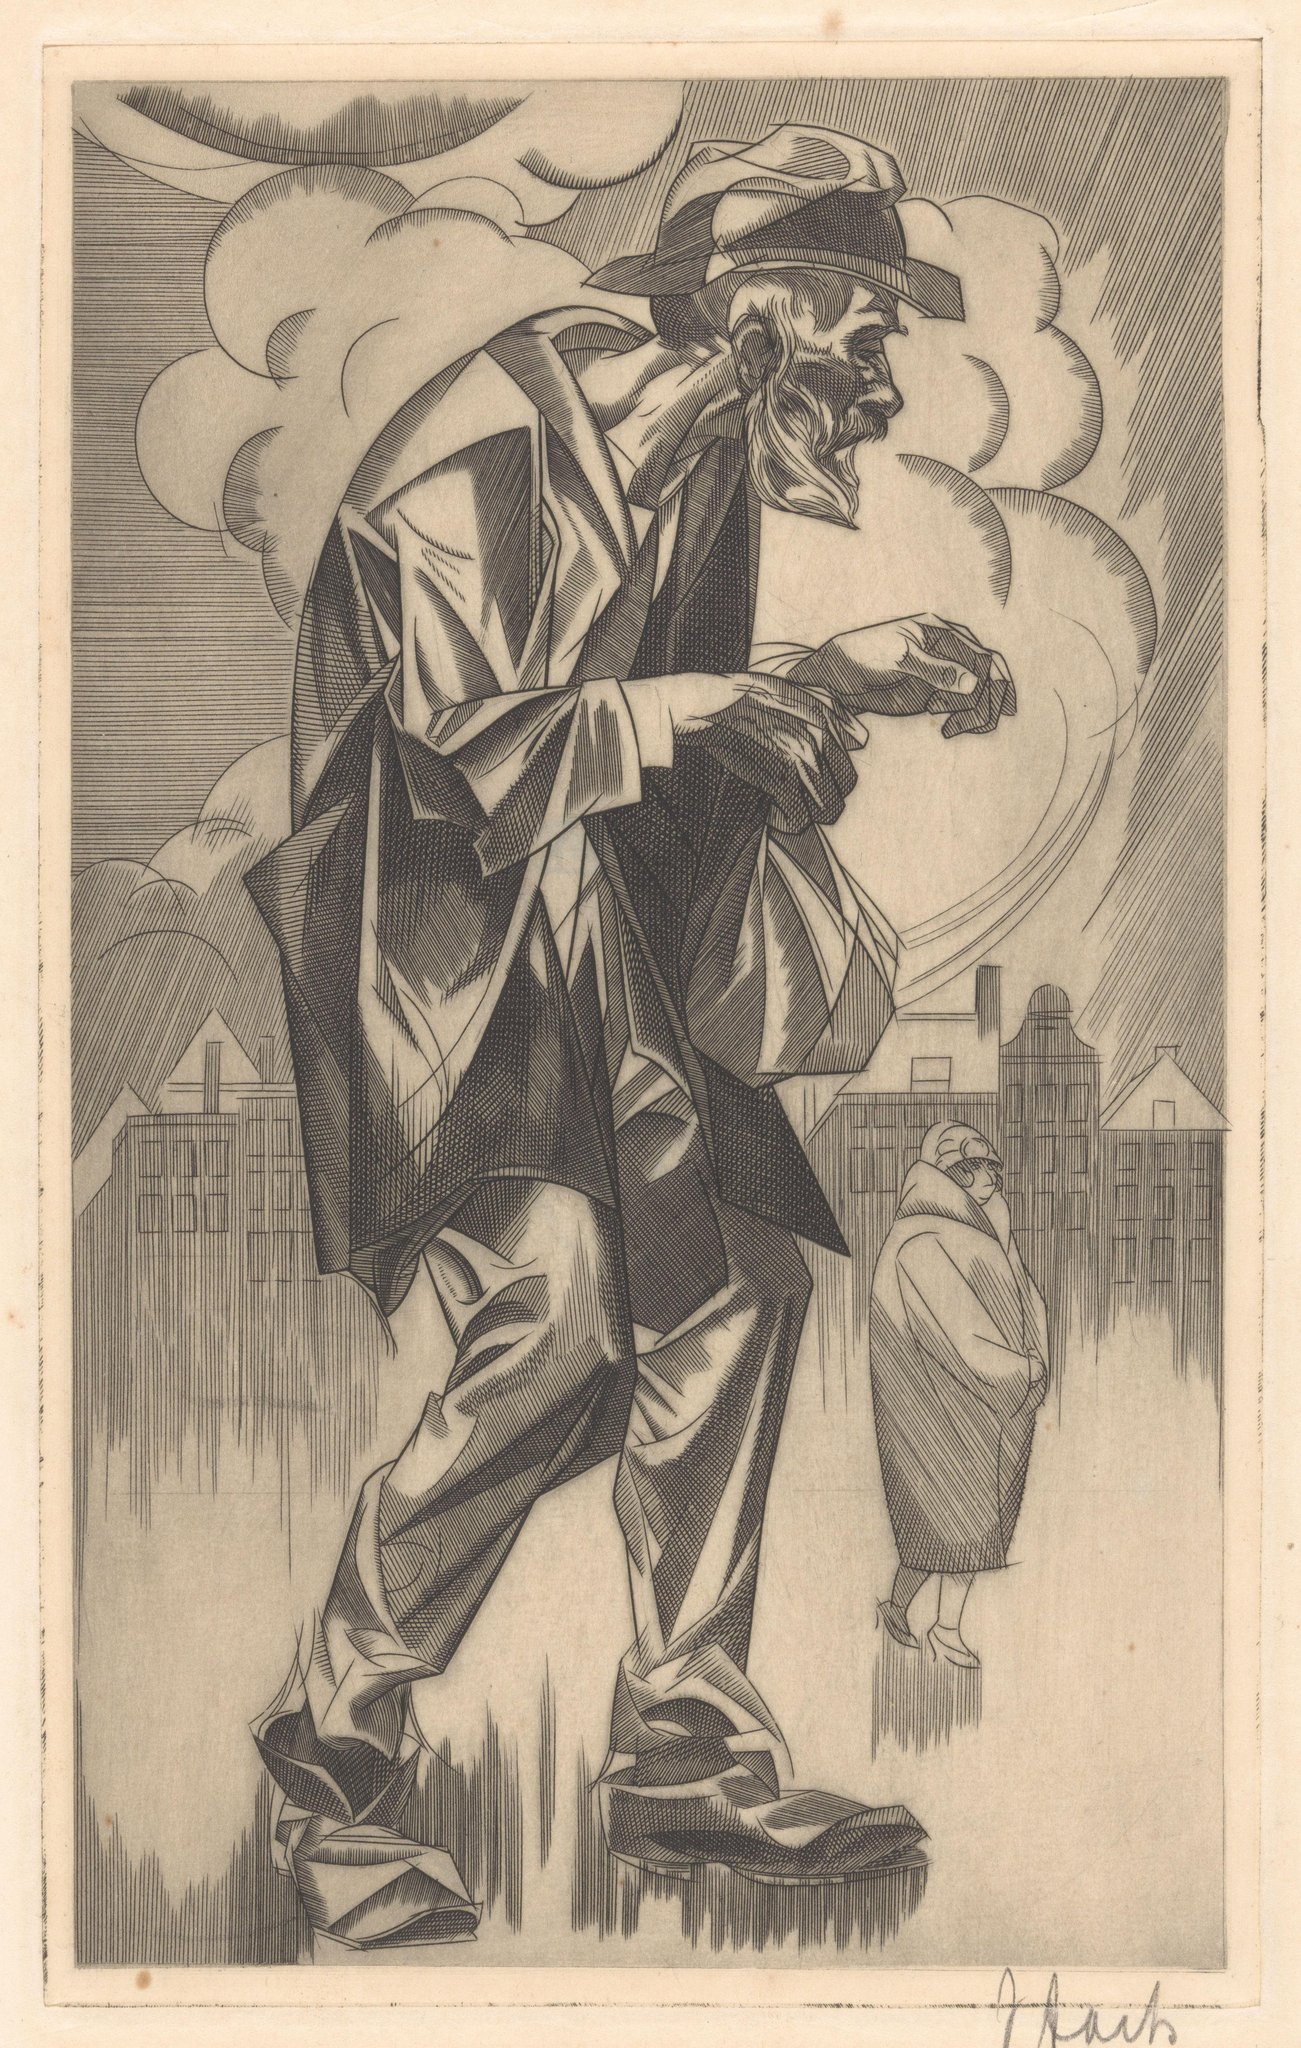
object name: print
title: Bedelaar lopend op straat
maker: johannes josephus aarts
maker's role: draughtsman, print maker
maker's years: 1871-1934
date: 1881-1934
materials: paper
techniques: engraving, intaglio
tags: container of textile material: bag, sack, beggar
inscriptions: collector's mark: Lugt 2228, collector's mark: Lugt 2760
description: Een bebaarde man met kromme rug, wandelend over straat met een zak in hand. Zijn jas hangt open en hij draagt een hoed. Op de achtergrond een vrouw in een mantel en een rij huizen.